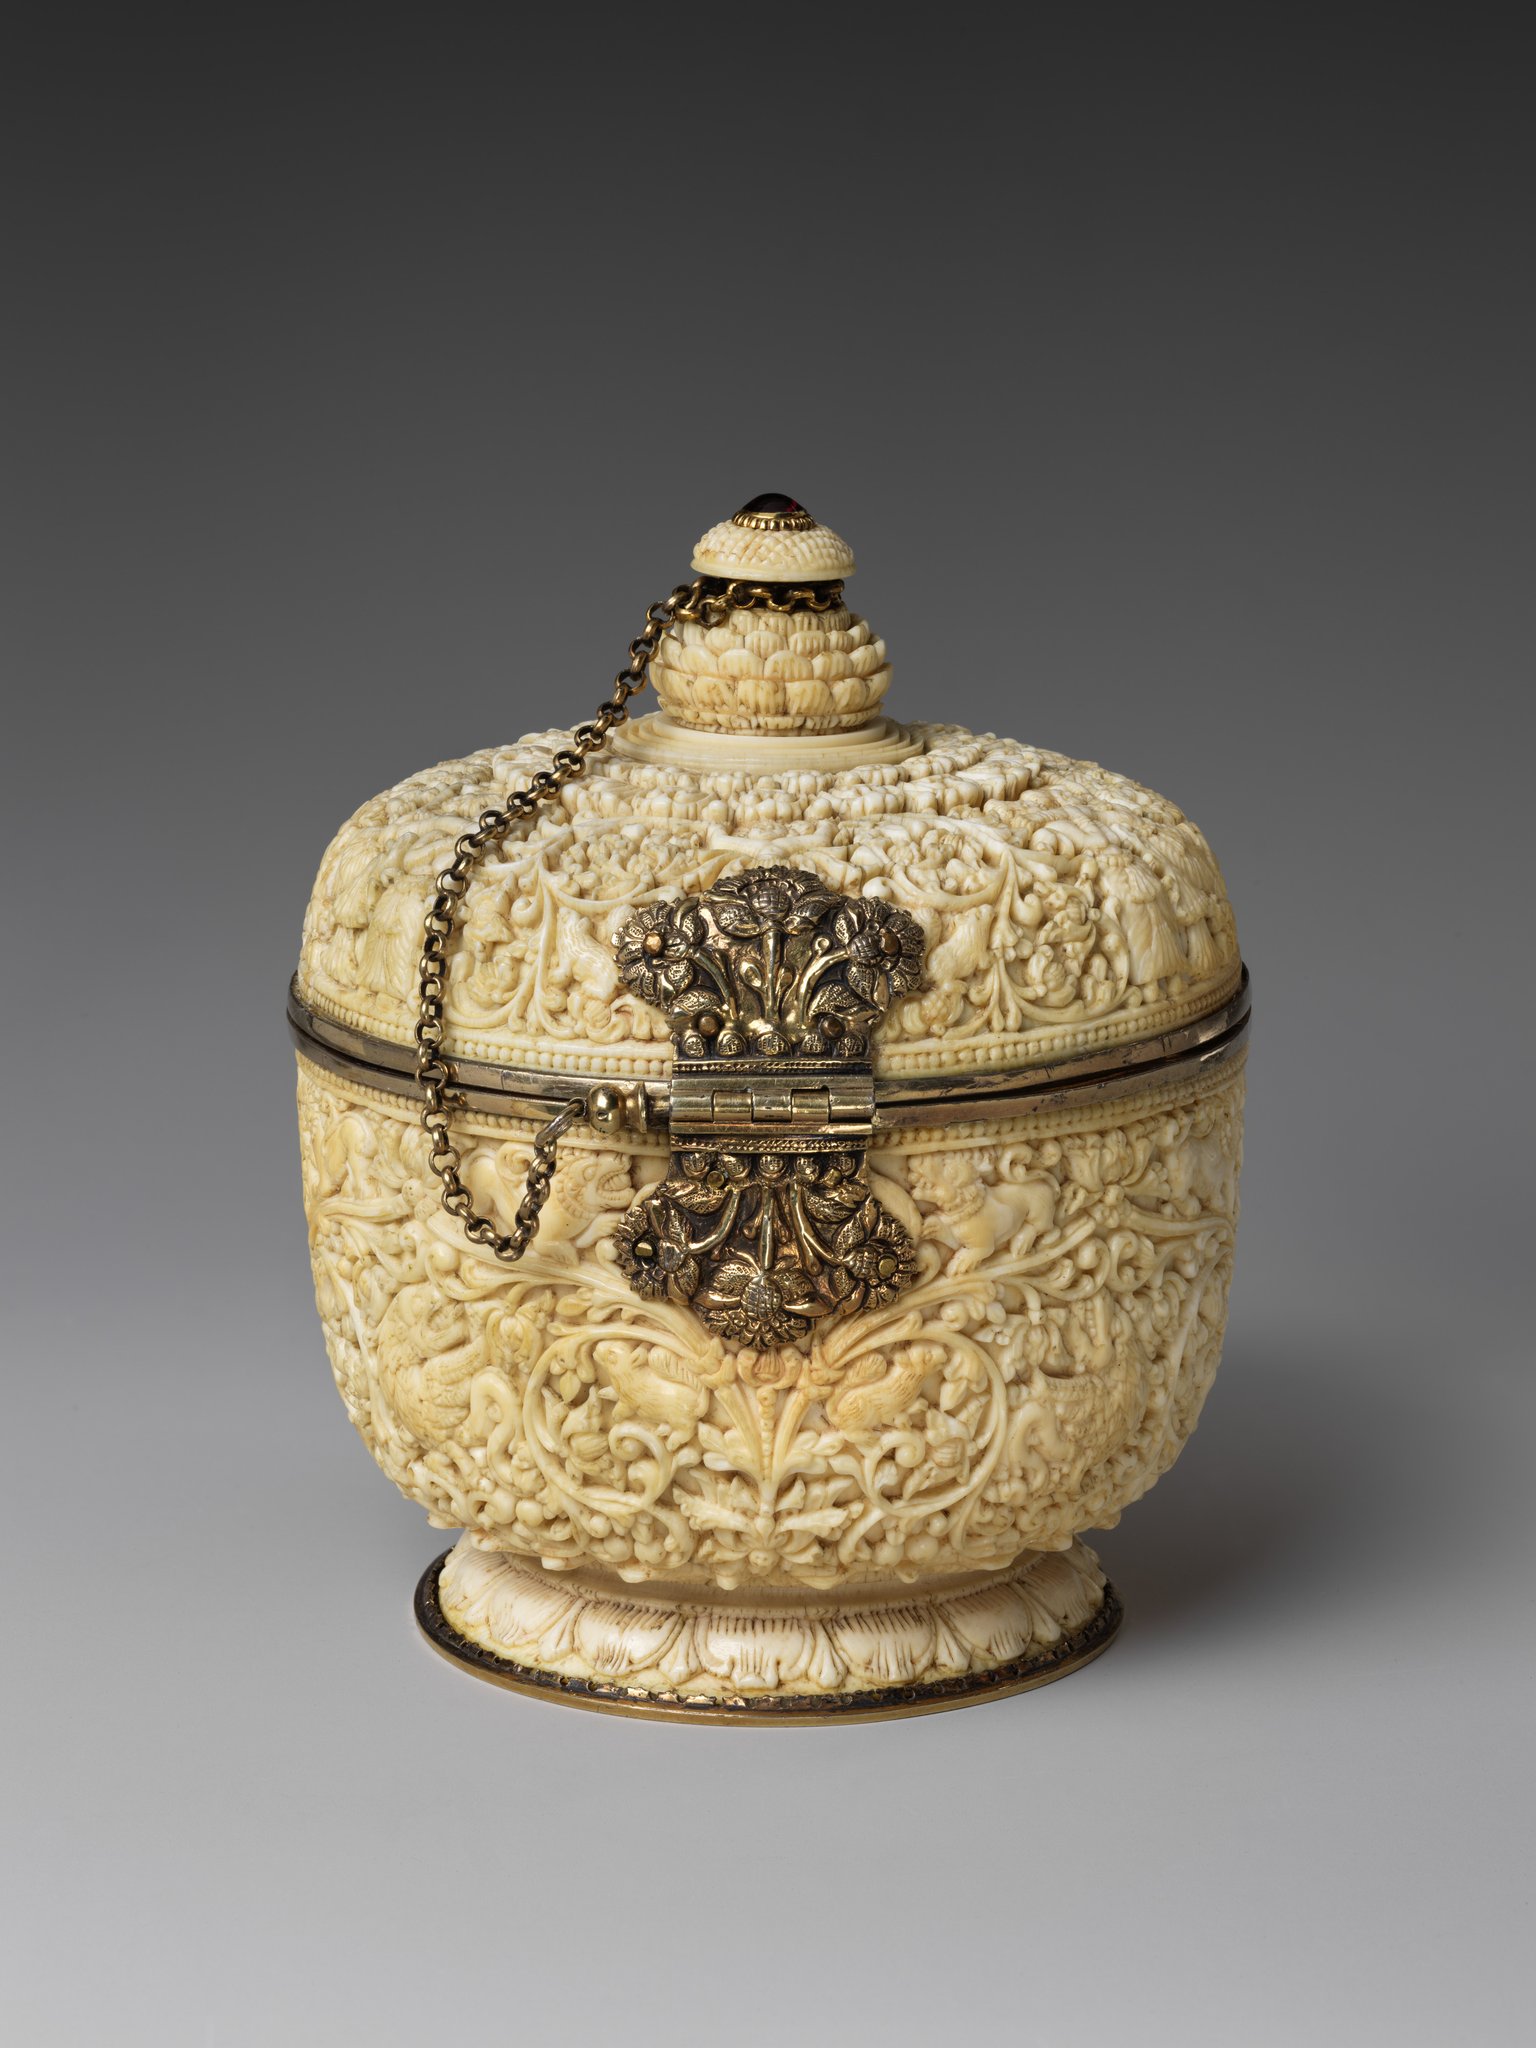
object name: covered box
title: Jewel casket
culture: sri lankan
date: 1634-1666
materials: gemstone, gold, ivory, metal, silver gilt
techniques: gilding, lining